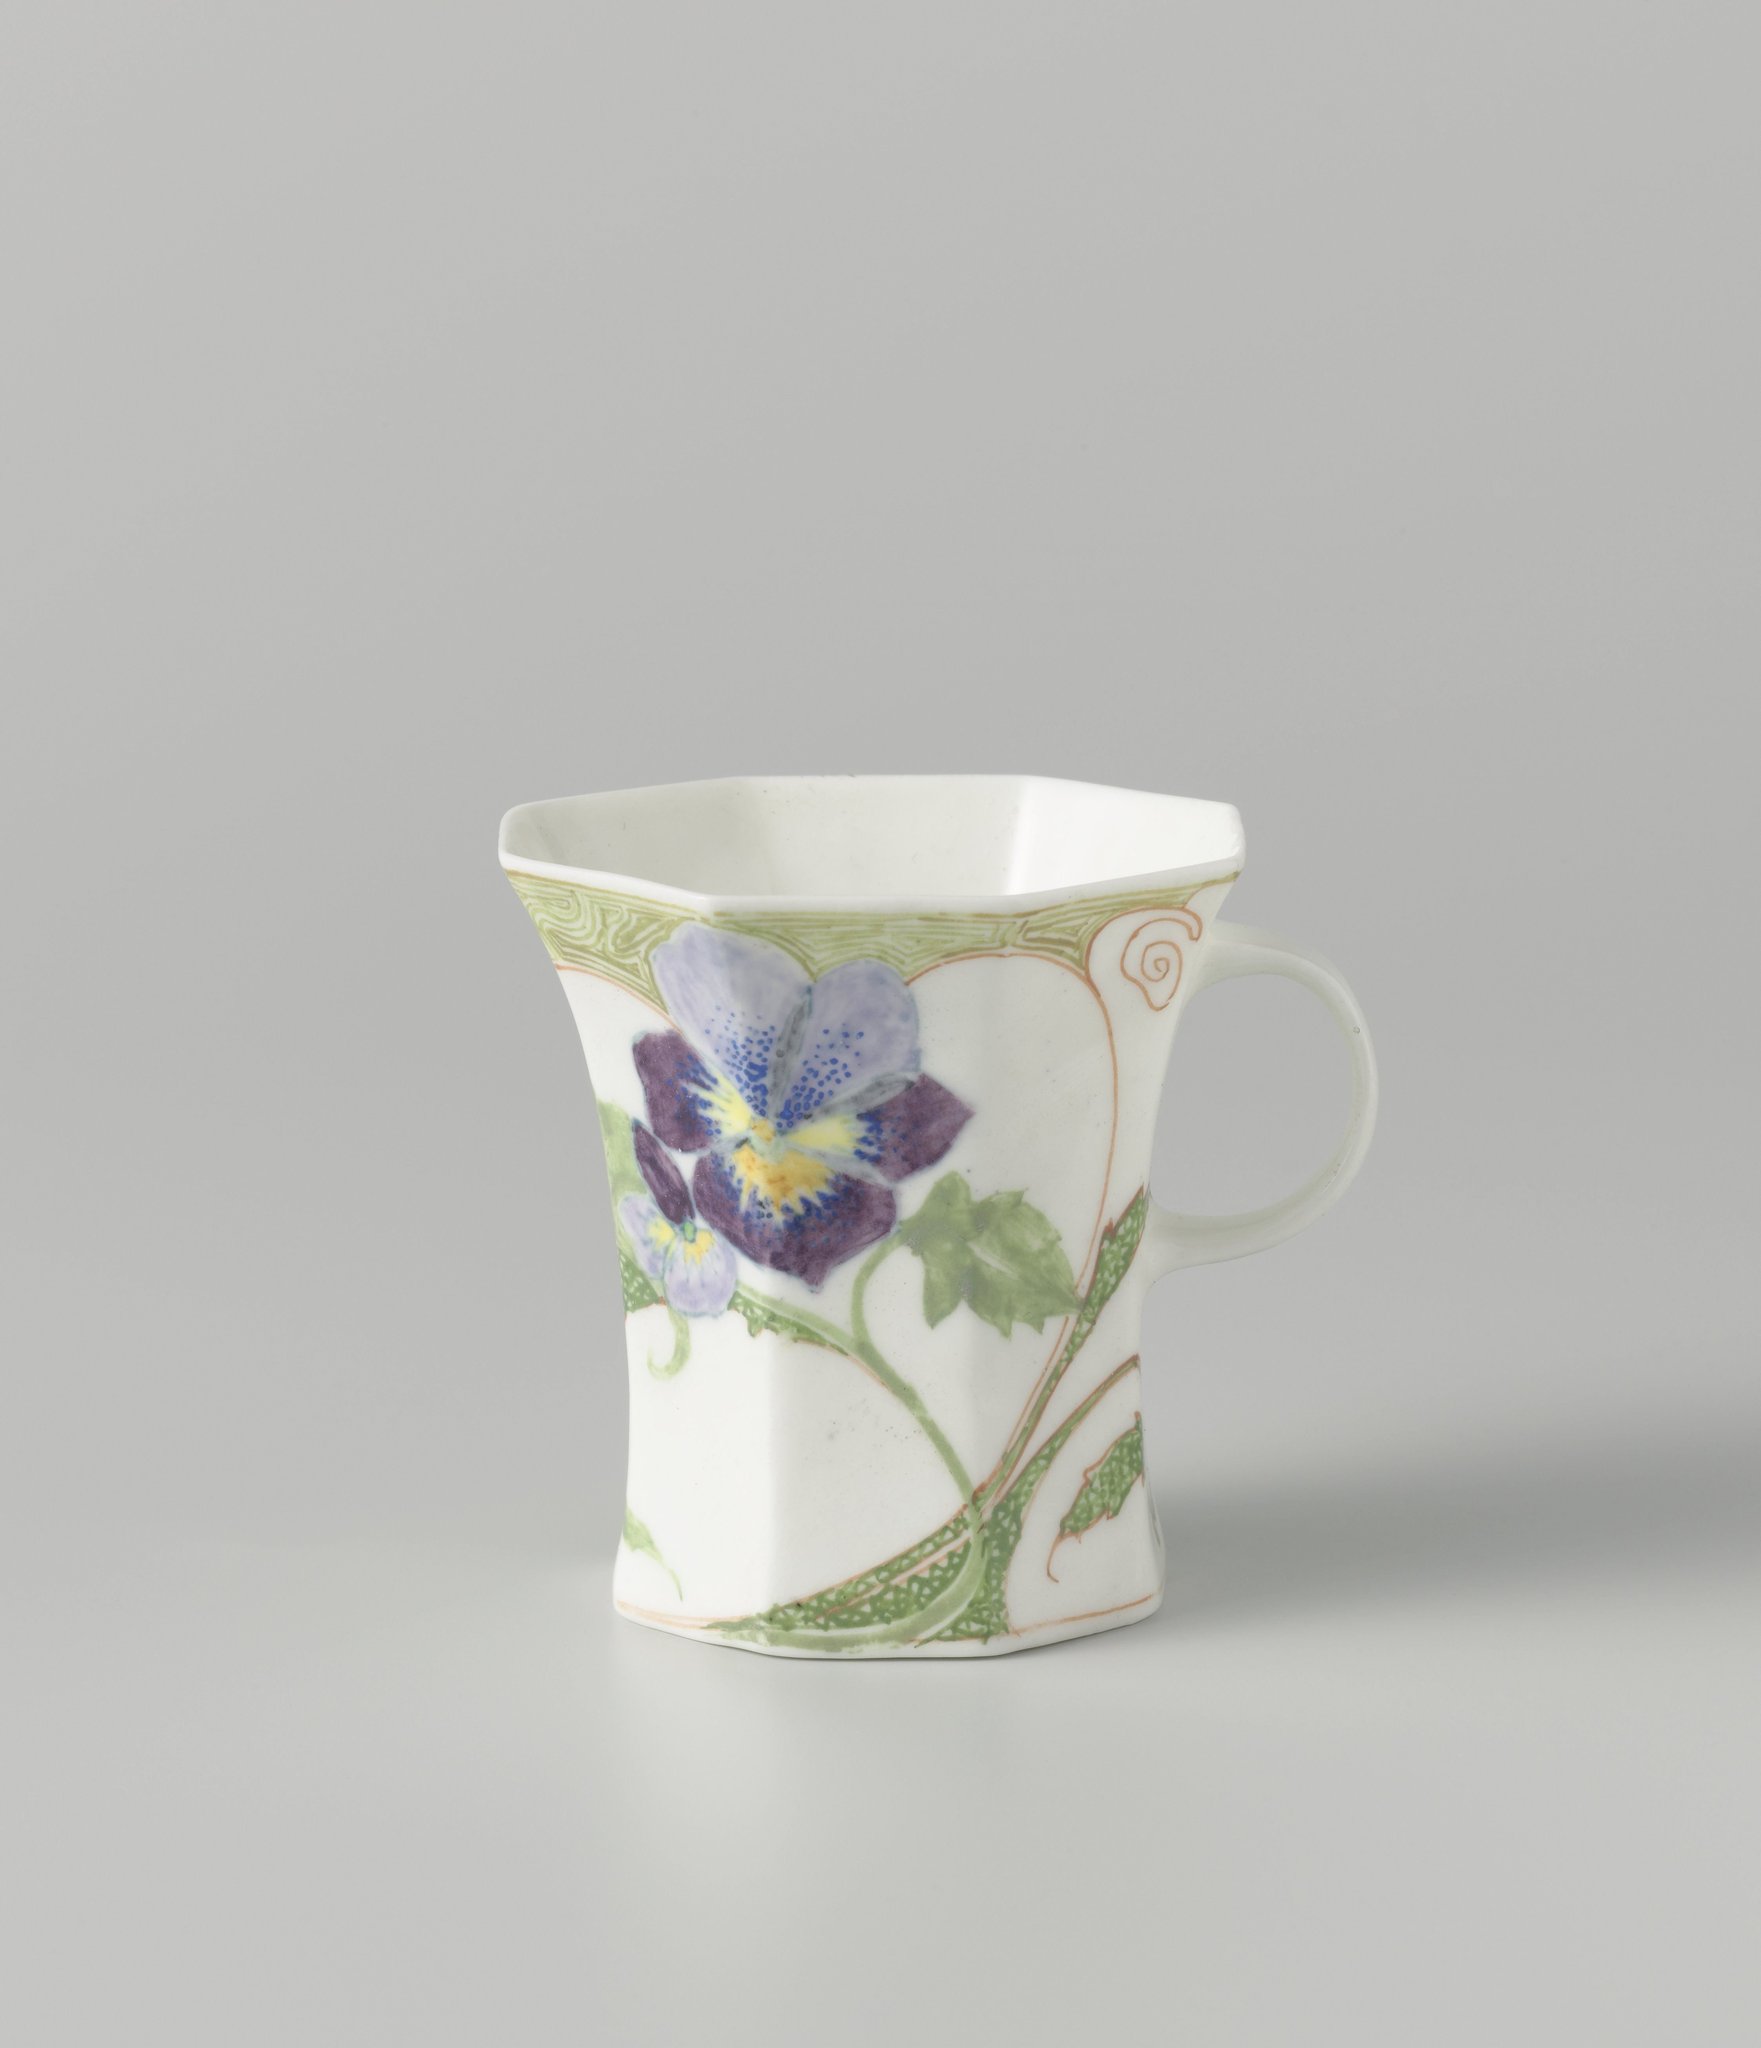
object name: cup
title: Kop, deel van een servies, beschilderd met violen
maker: c.w.j. t hart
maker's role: plateelschilder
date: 1913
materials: porcelain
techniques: painted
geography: the hague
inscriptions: mark: ‘kroon, Rozenburg, ooievaar, den Haag (boven elkaar); links het merk voor 1913, rechts het werkordernummer 332 (op een kop 333); onder het schildersmerk van C.W.J. 't Hart.’